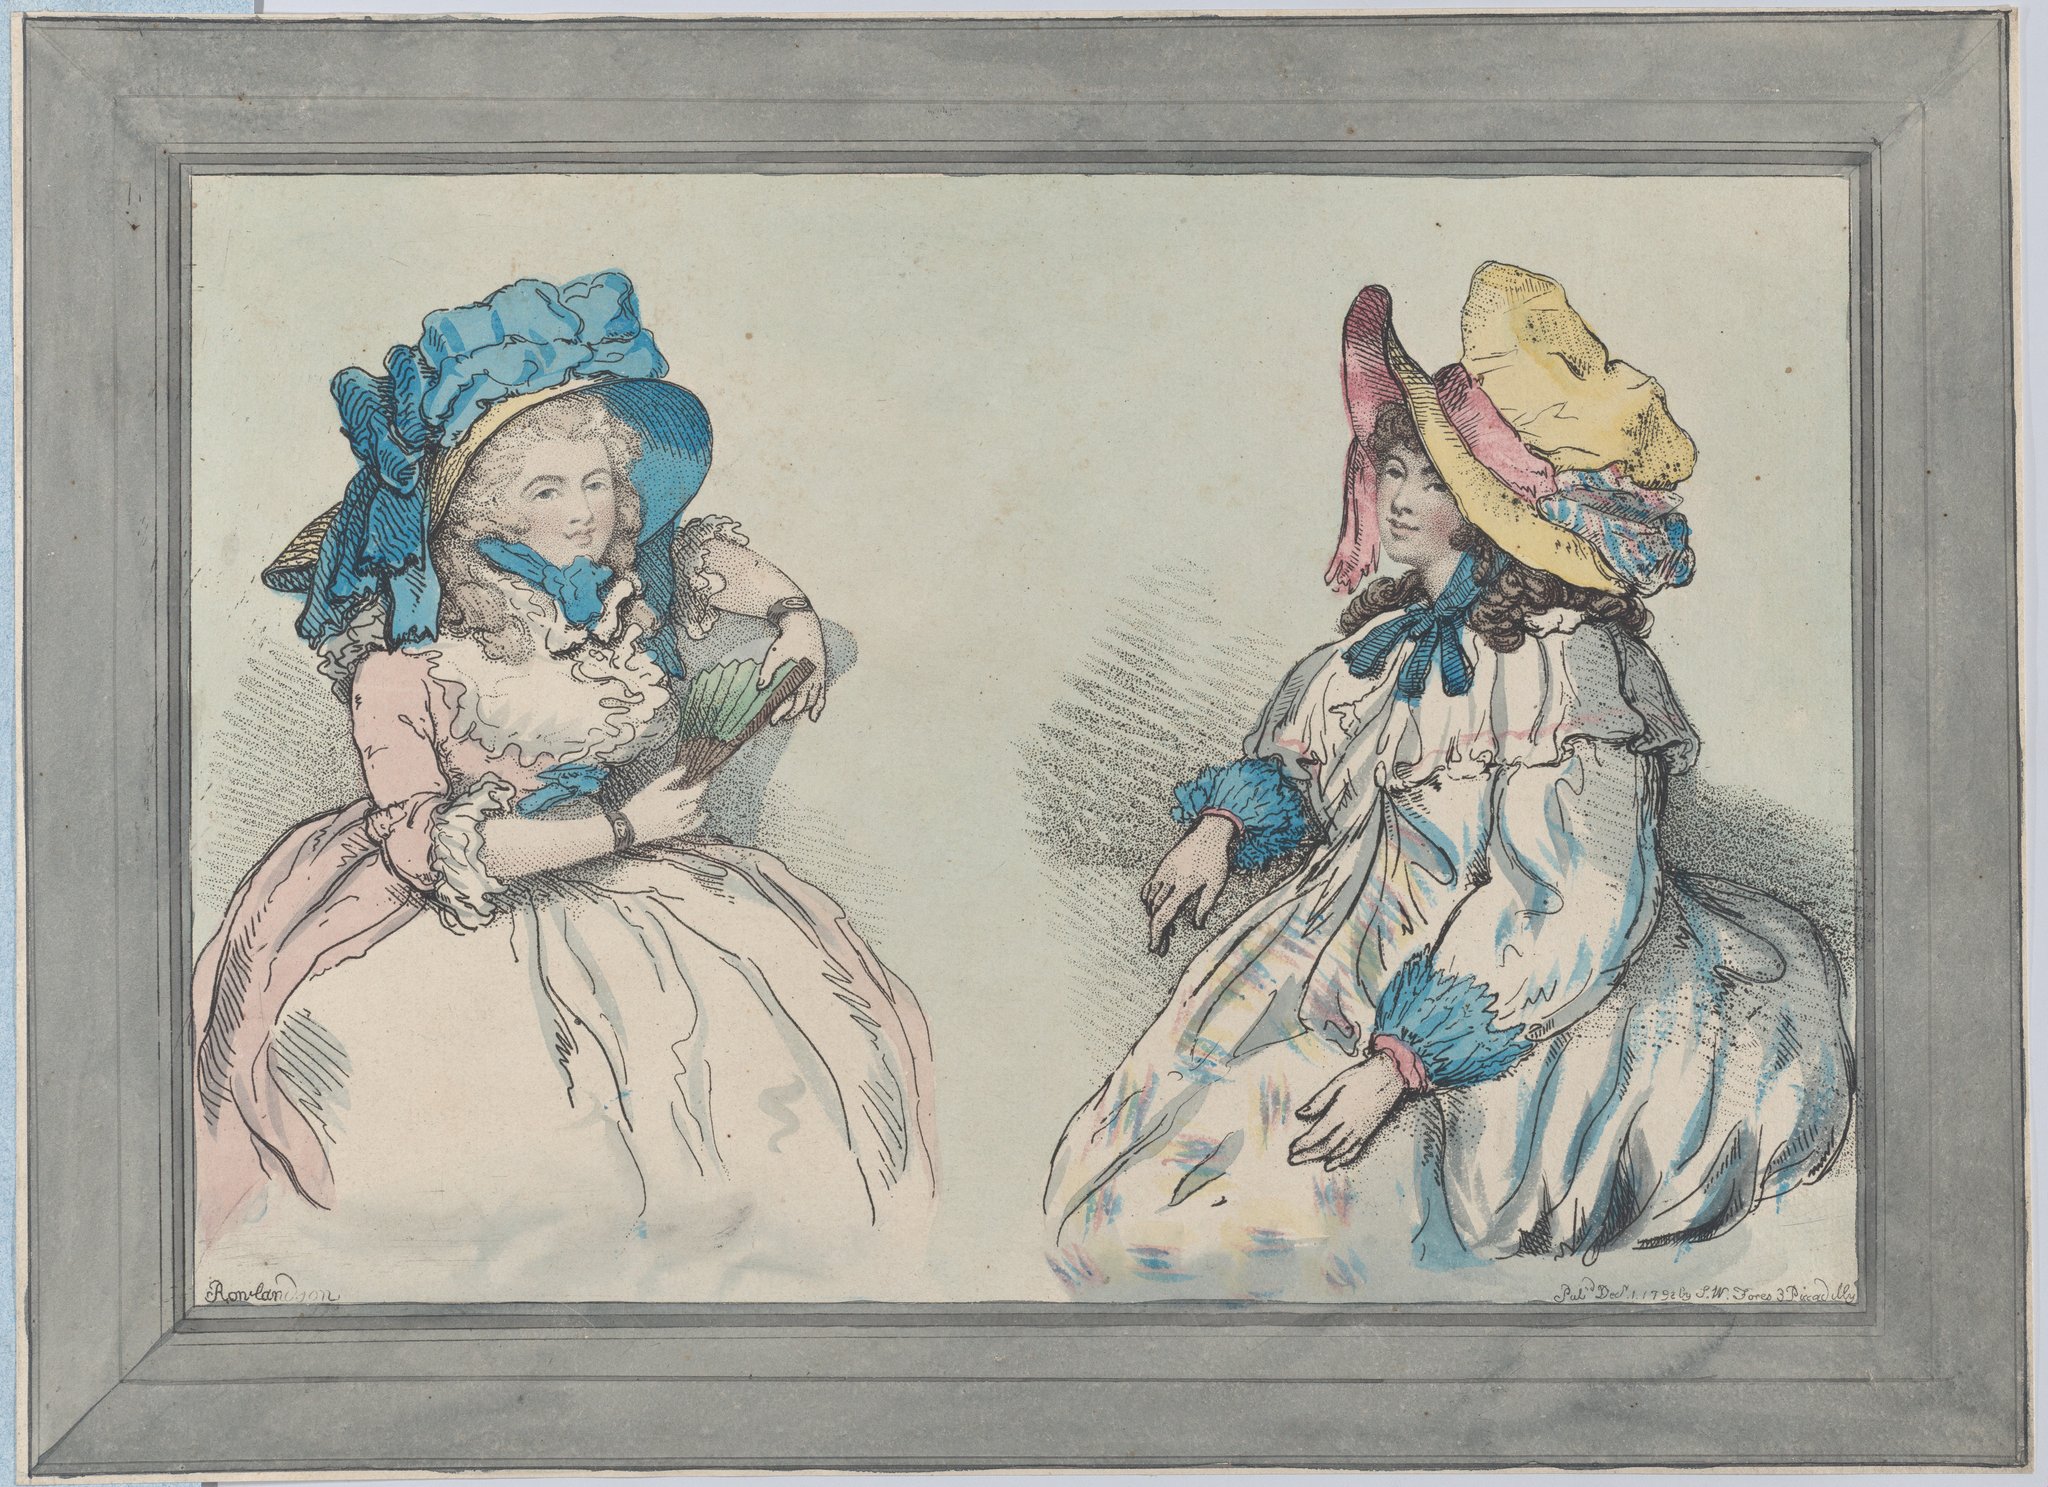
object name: print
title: Beauties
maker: thomas rowlandson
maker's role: artist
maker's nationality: british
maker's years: 1757-1827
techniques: hand coloring, etching, engraving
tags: women